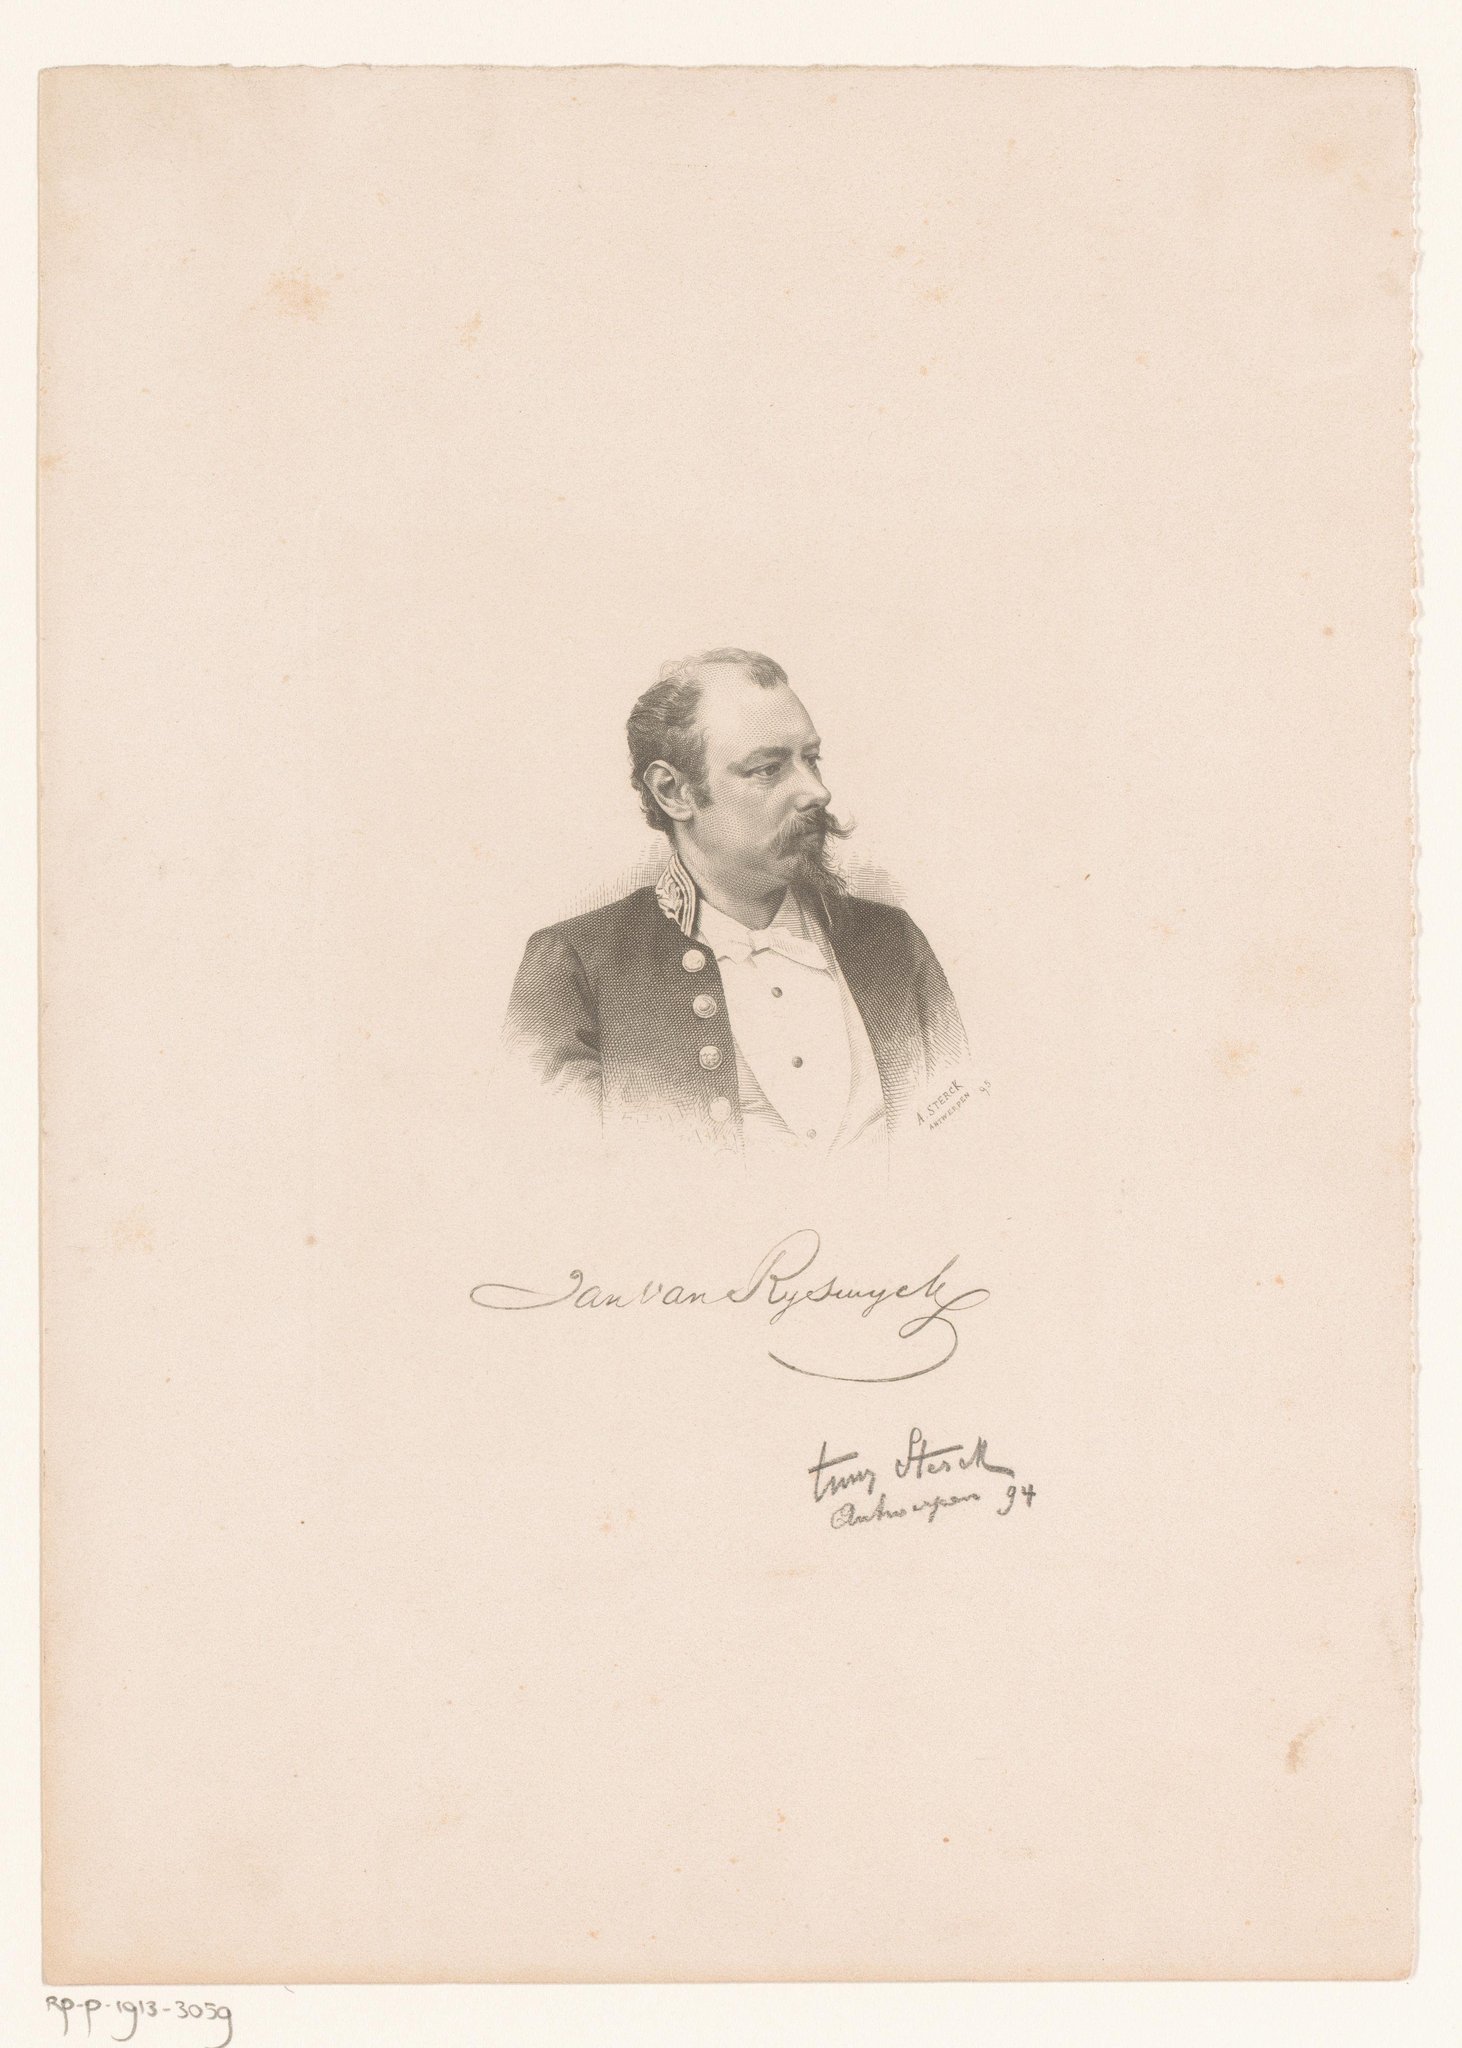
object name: print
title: Portret van Jan van Rijswijck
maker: arthur sterck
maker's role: print maker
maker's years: 1868-1897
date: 1895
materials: paper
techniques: etching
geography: antwerp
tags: politician, historical persons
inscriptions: collector's mark: Lugt 2228